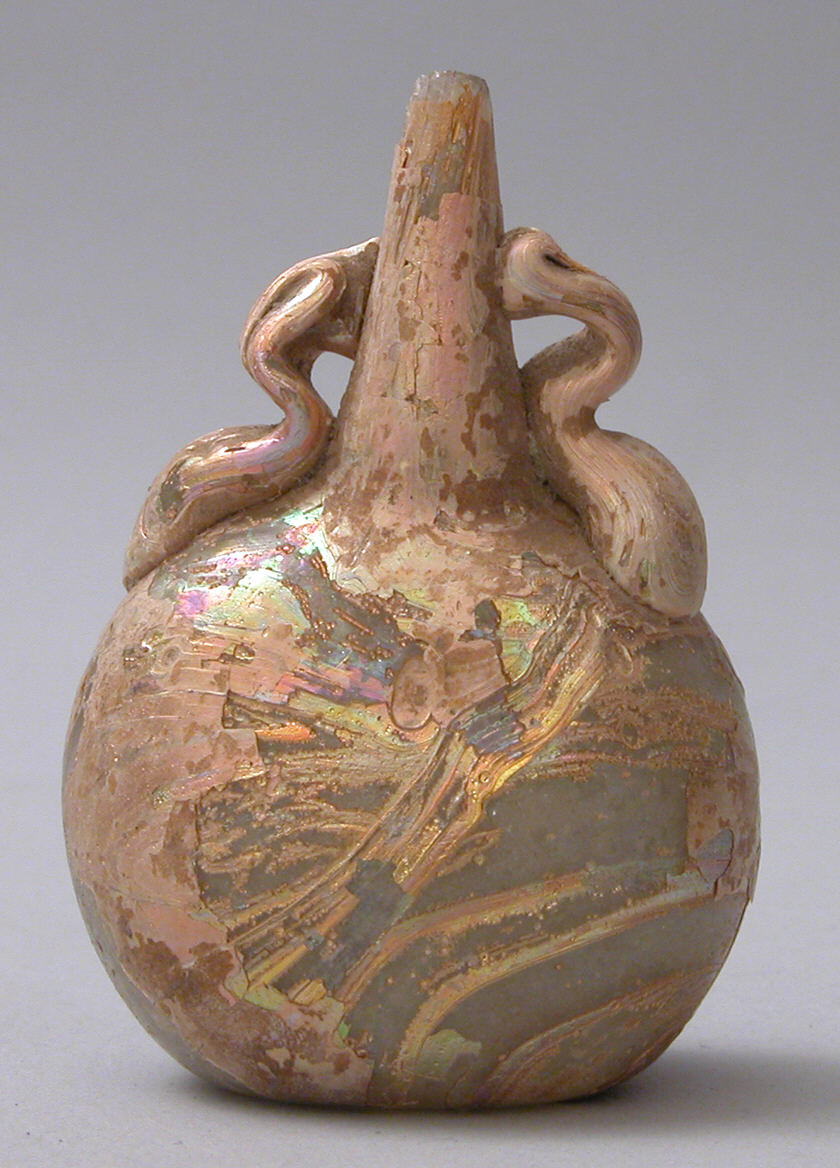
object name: flask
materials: glass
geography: egypt or syria